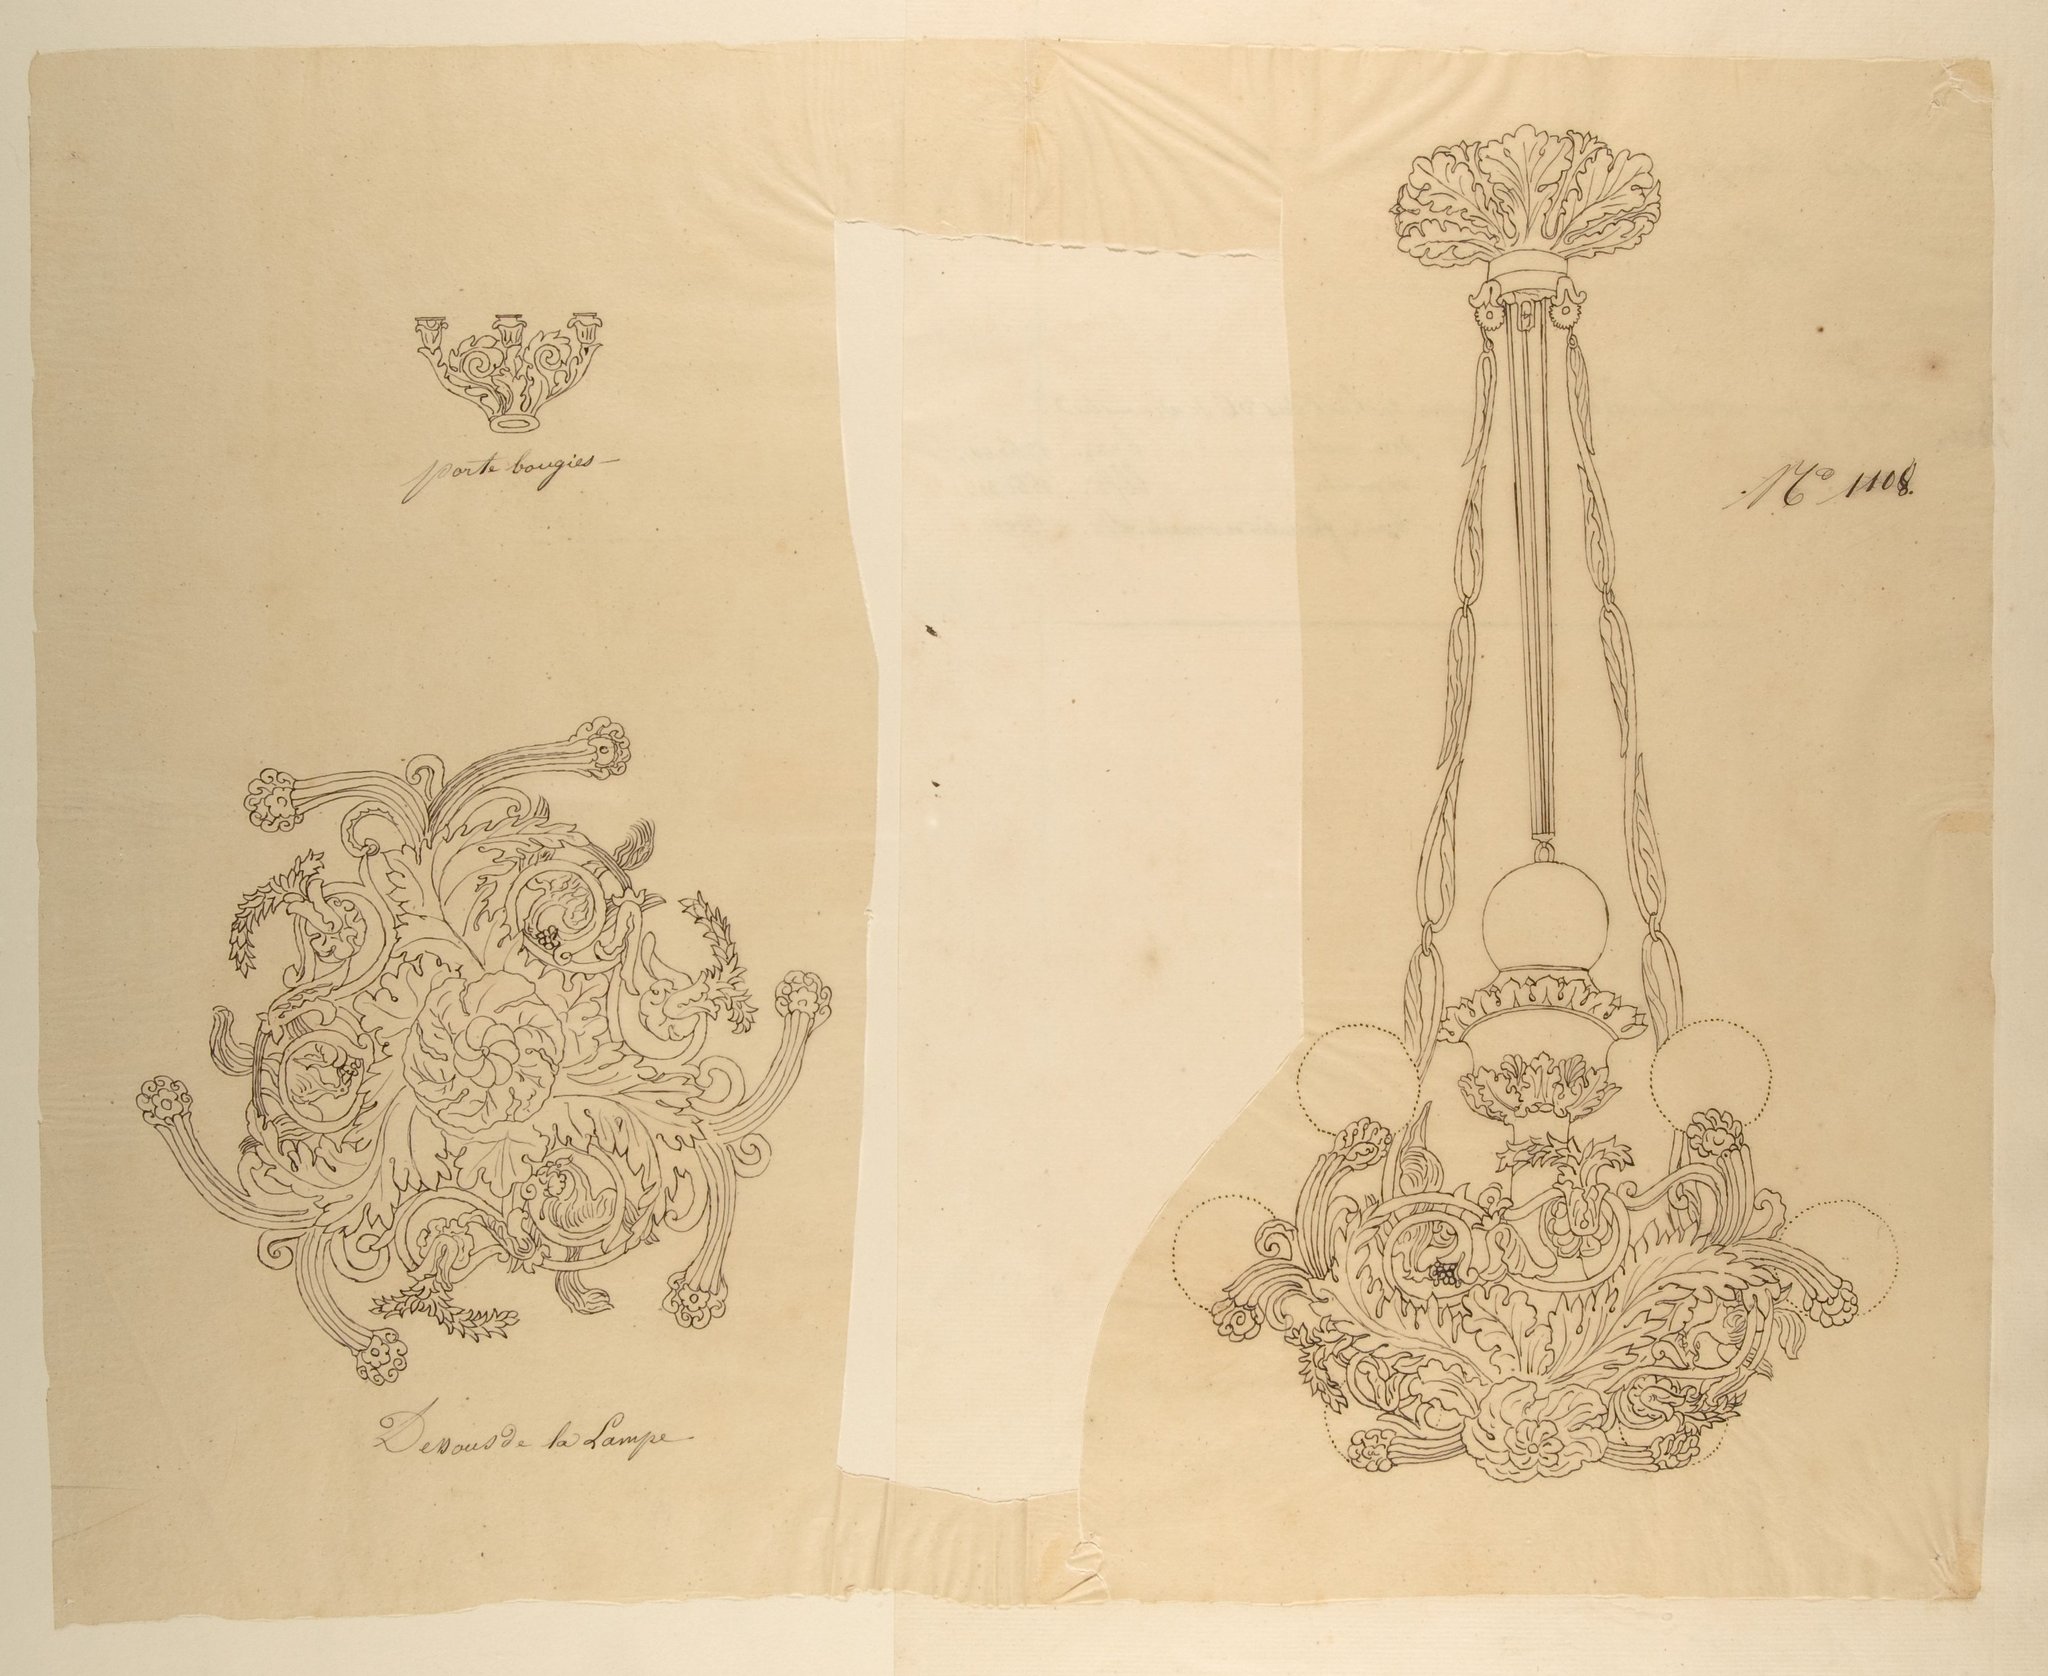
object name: drawing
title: Design for a Chandelier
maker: anonymous, french, 19th century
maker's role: artist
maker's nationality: french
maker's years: 1800-1900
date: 1801-1900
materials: ink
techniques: pen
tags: chandelier